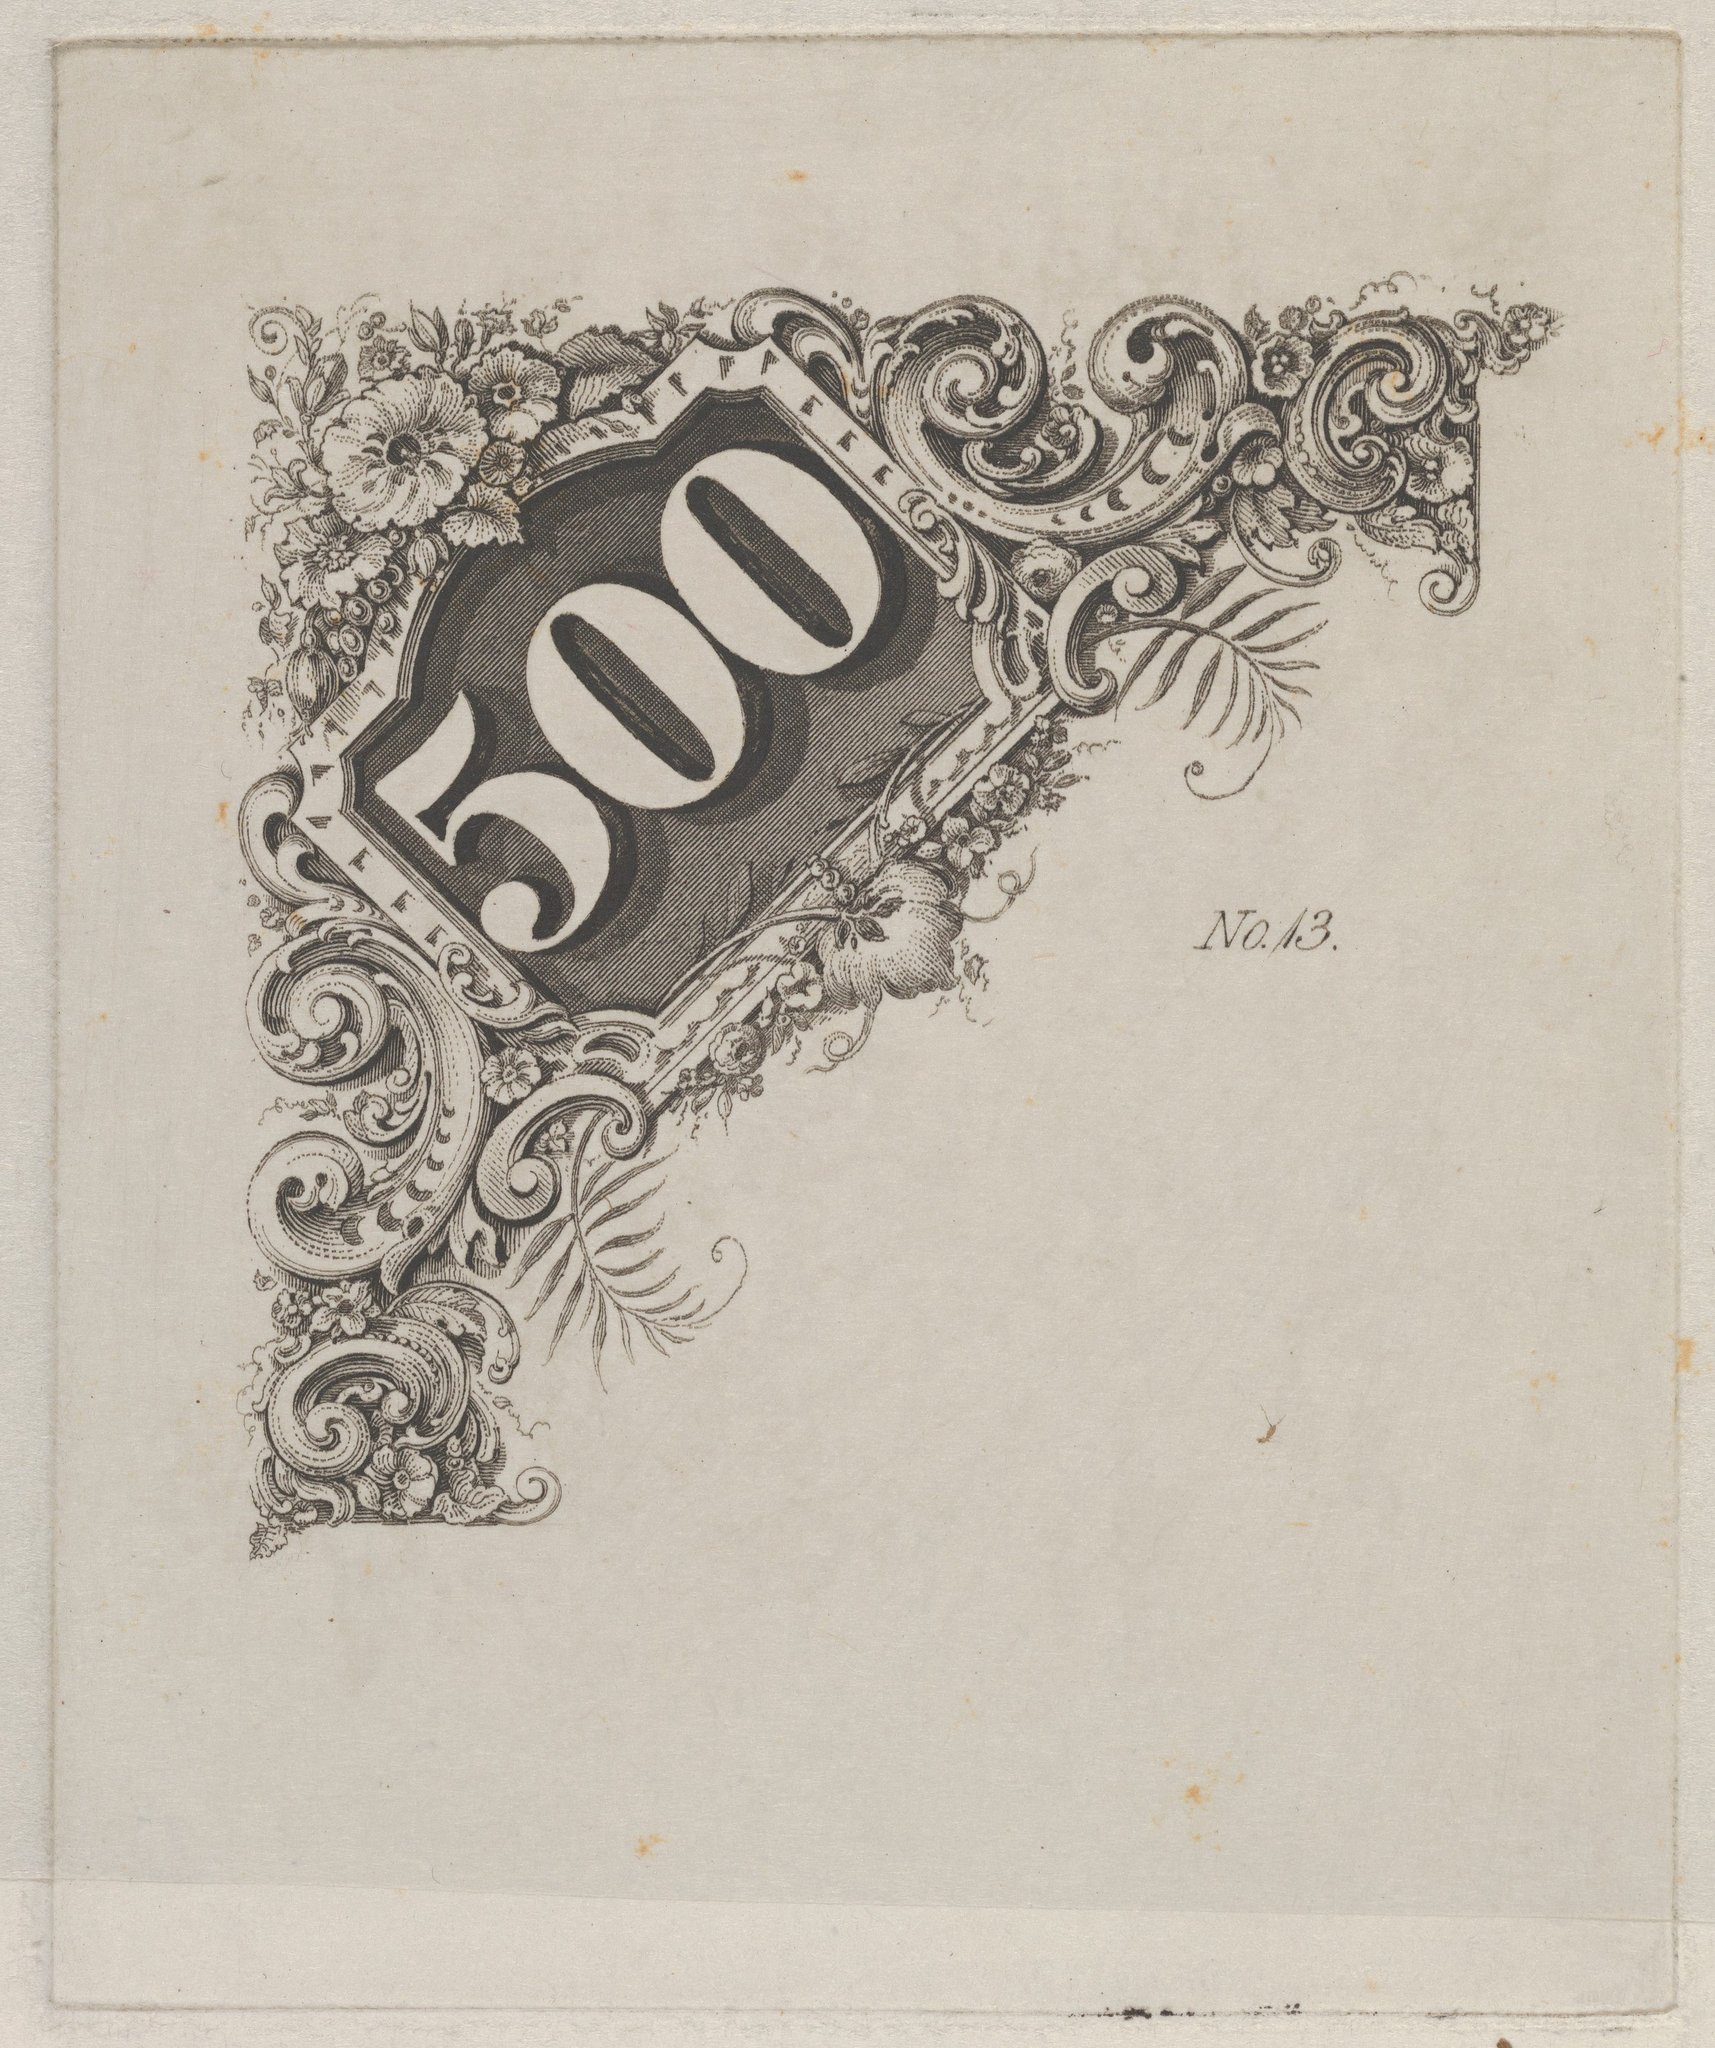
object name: print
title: Banknote motif: number 500 in an ornamental frame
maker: cyrus durand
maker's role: artist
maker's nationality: american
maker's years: 1787-1868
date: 1824-1842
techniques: engraving, etching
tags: ornament,flowers